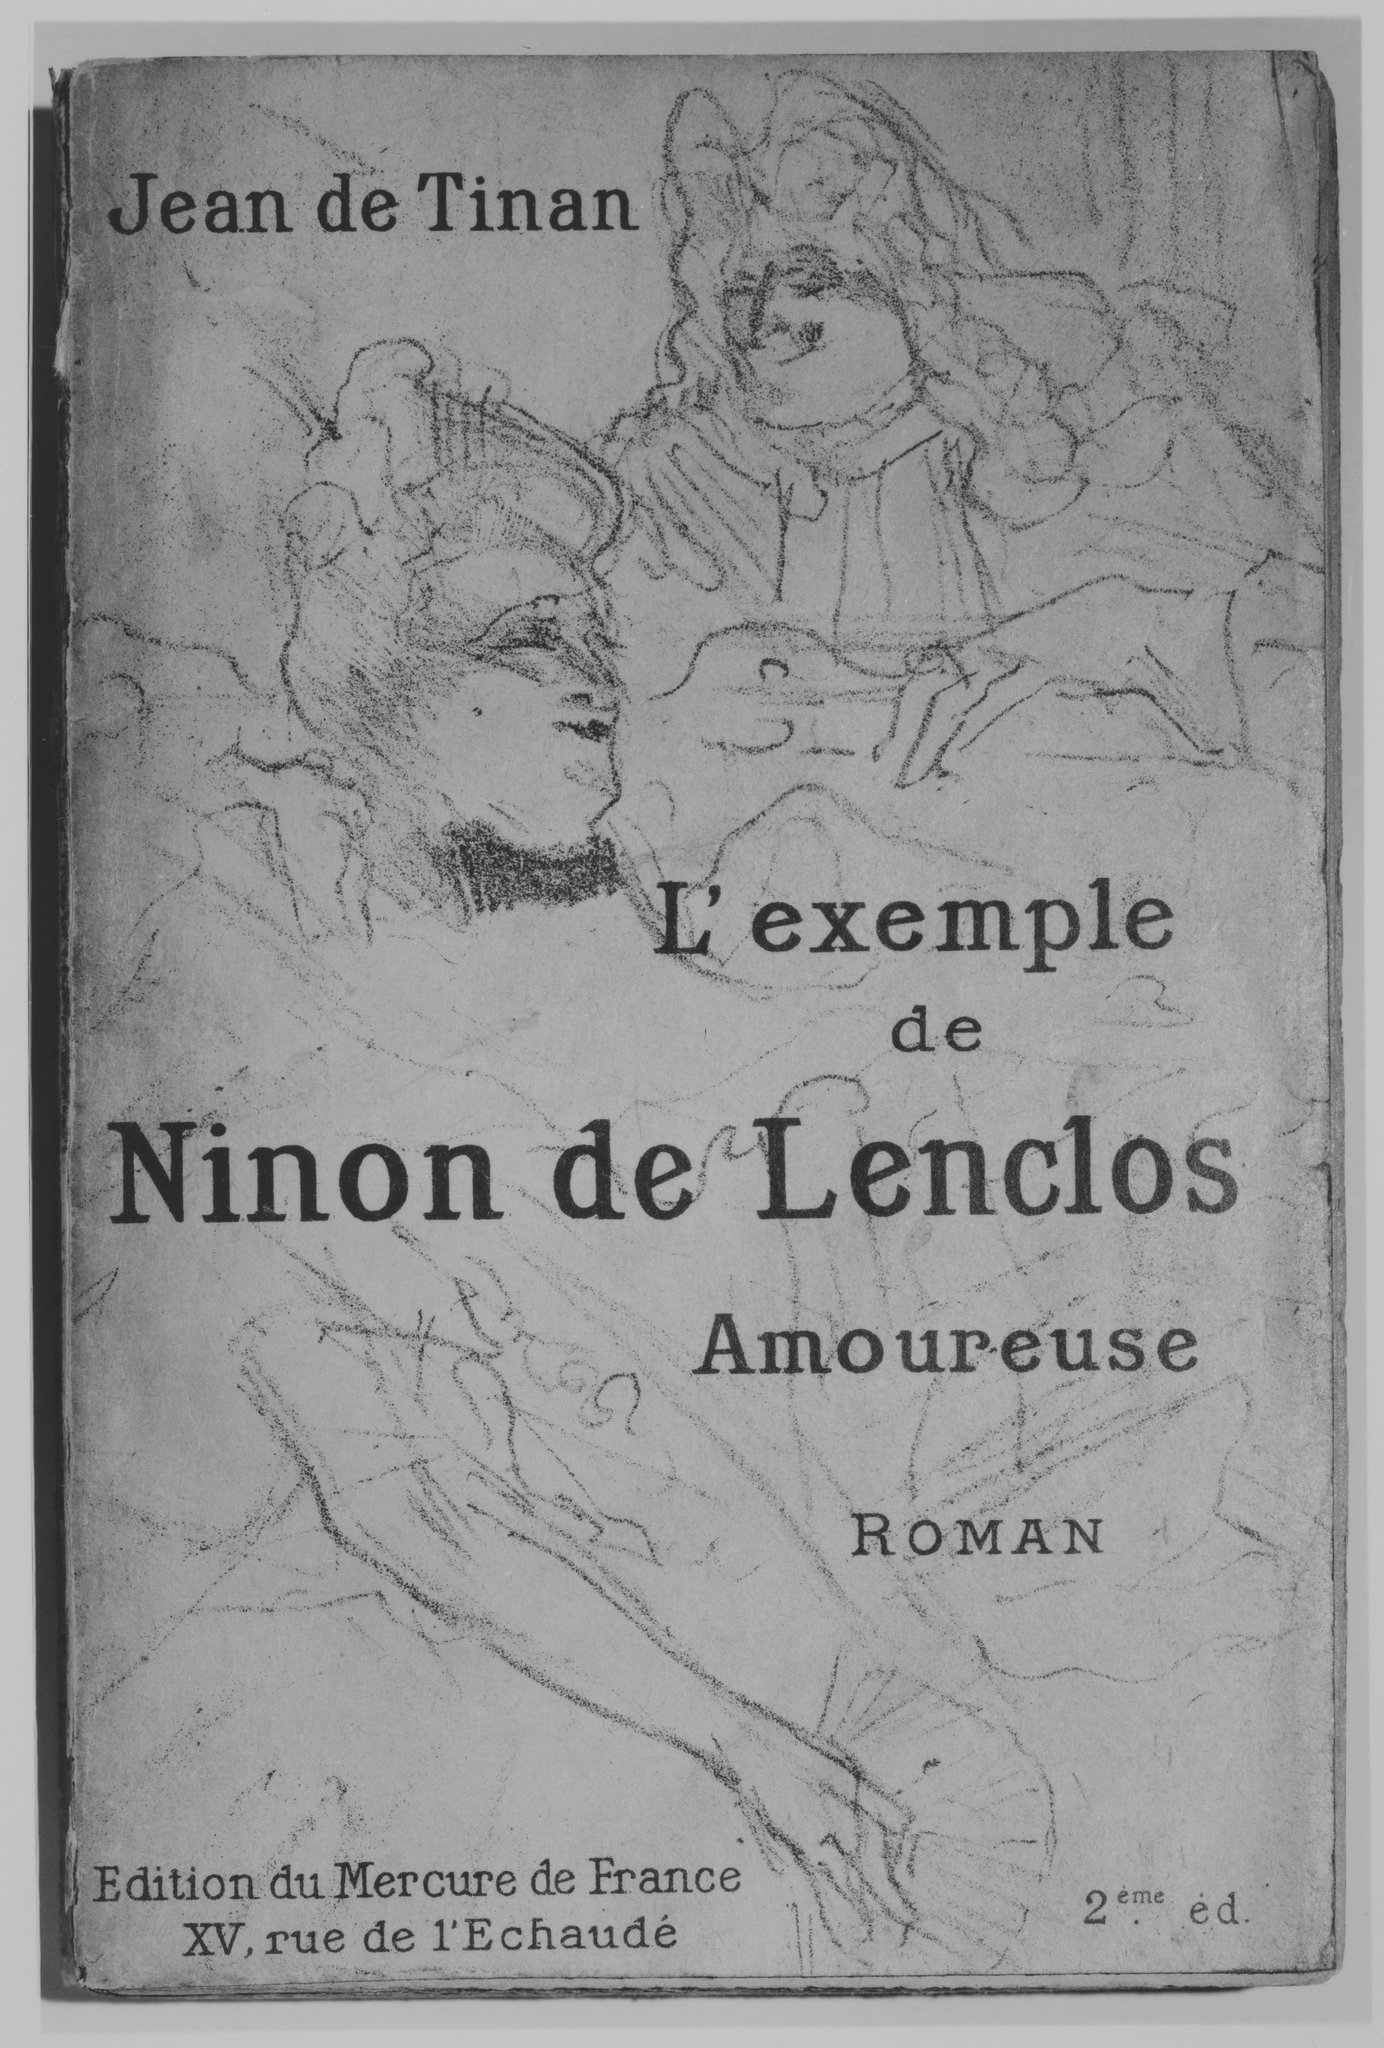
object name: print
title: L'Exemple de Ninon de Lenclos, Amoureuse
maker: henri de toulouse-lautrec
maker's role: artist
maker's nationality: french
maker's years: 1864-1901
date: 1898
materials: parchment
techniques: lithograph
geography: france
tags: men,women